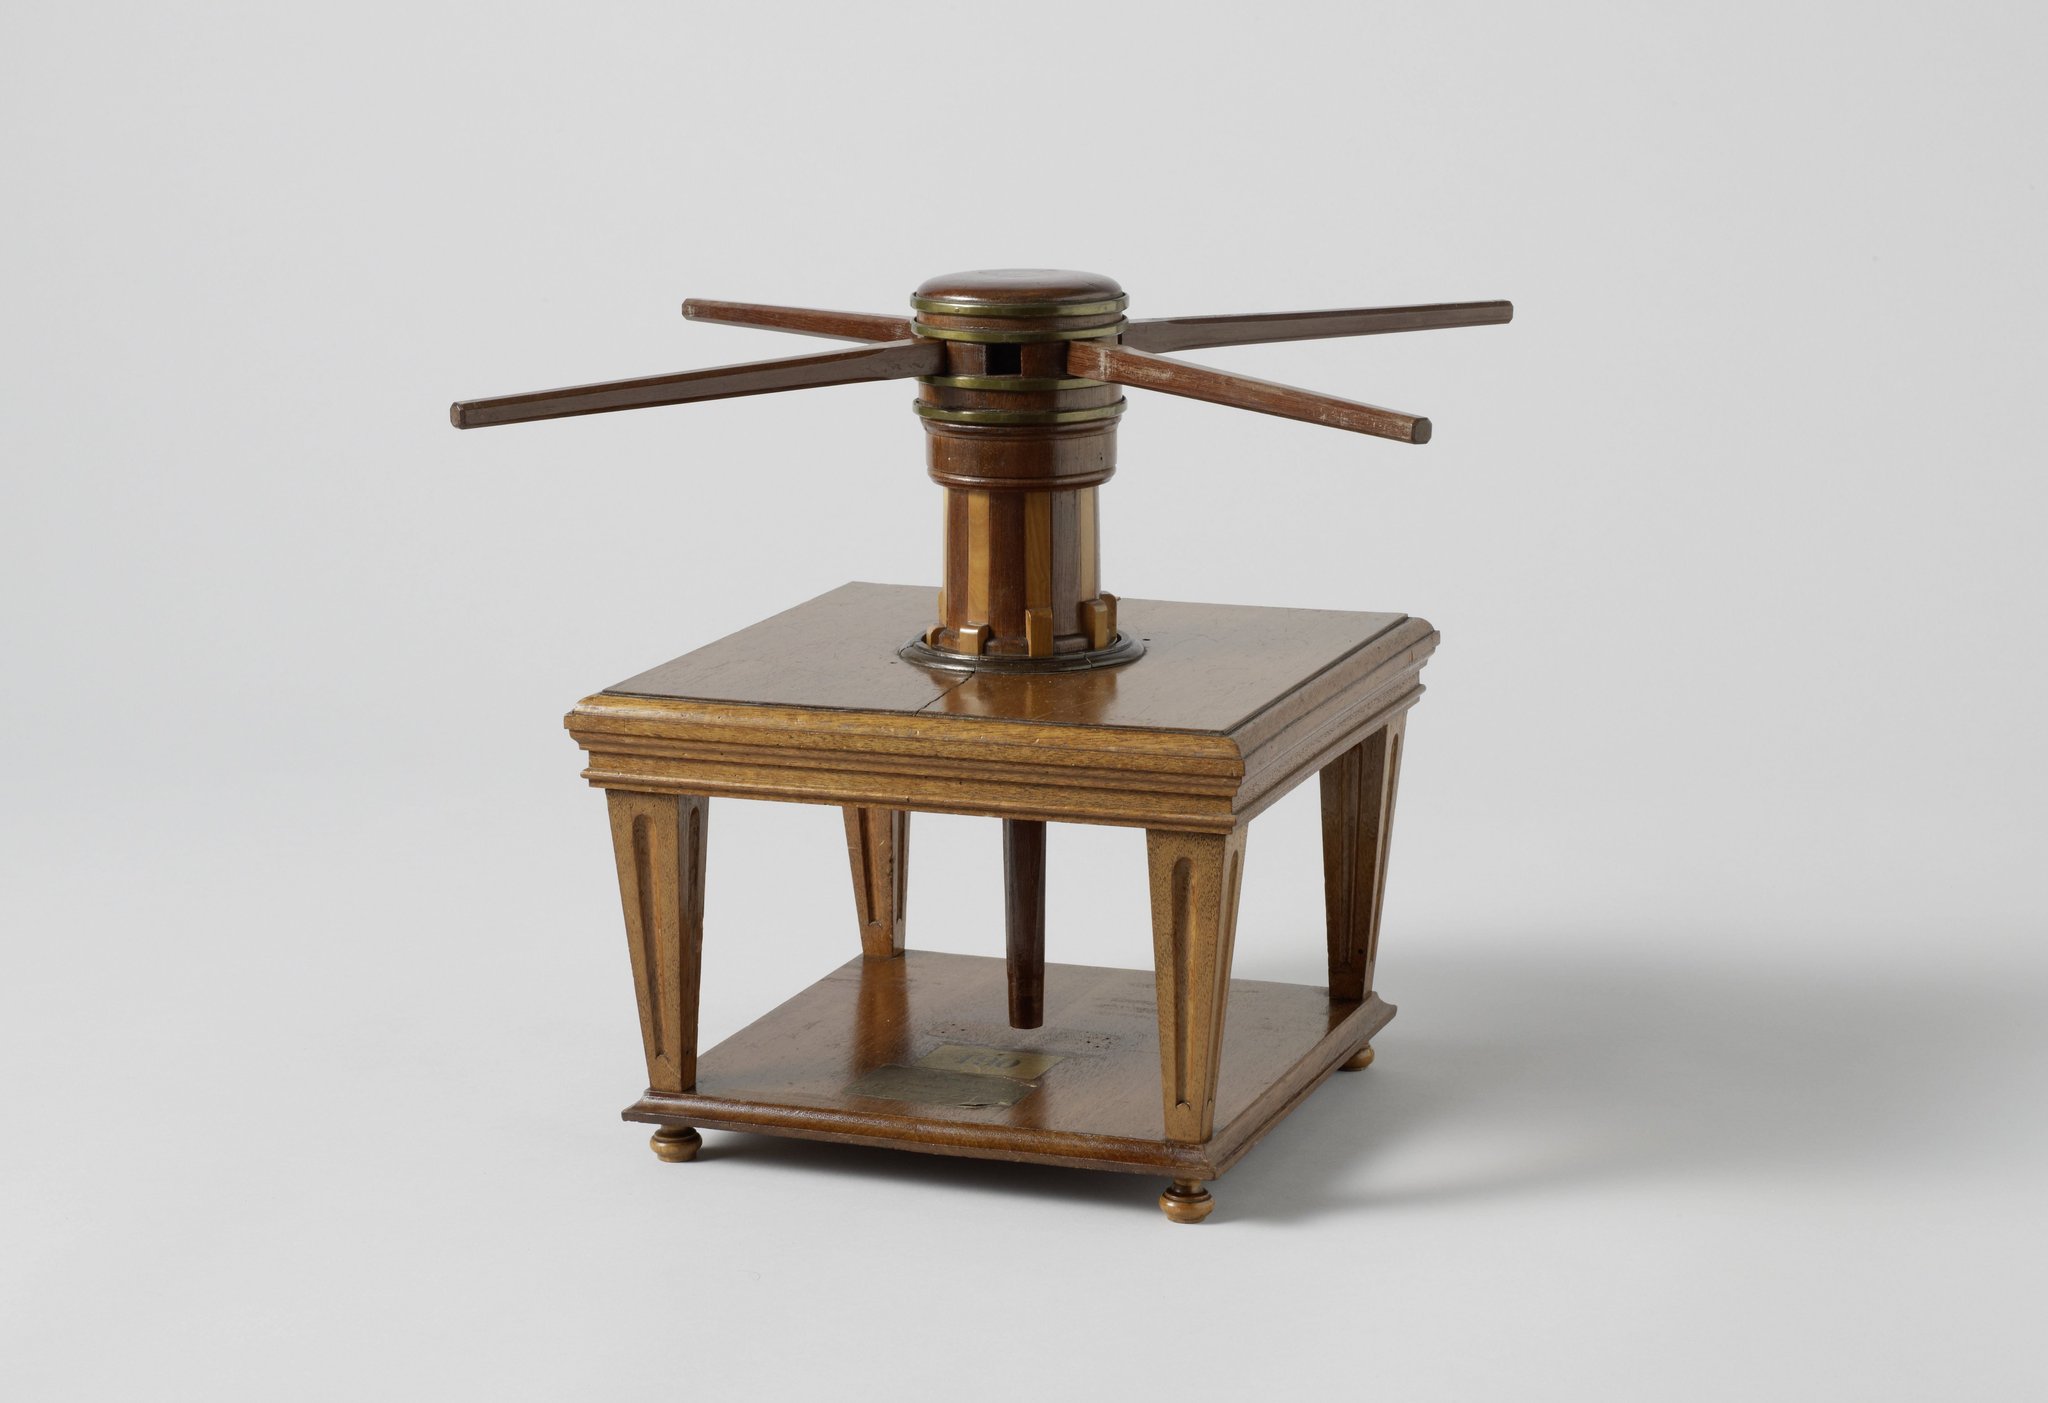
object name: demonstration model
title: Model of a Capstan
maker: jochem pietersz. asmus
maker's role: constructeur, directeur, equipagemeester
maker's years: 1755-1837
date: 1794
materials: brass, wood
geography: hellevoetsluis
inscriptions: inscription, on the lower base: ‘ASMUS / Invent 1794 / HellevoetSluys’, label, on the lower base: ‘190’ former inventory label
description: Model van een kaapstander in een houten frame van twee niveaus. Het is een kaapstander voor acht windbomen en heeft geen pallen om het teruglopen te voorkomen. De houten koning loopt door tot op het benedenniveau. De trommel is geheel rond, de kiezen steken niet uit behalve bij de hiel waar zij verdikt zijn en kunnen op en neer bewegen. Onder de trommel is een hellend vlak aangebracht, waardoor de kiezen bij het ronddraaien op en neer bewegen en met hun verdikking de lijn op de trommel opschuiven. Het hellend vlak kan onder de trommel vandaan gehaald worden. Schaal 1:10 (schatting).